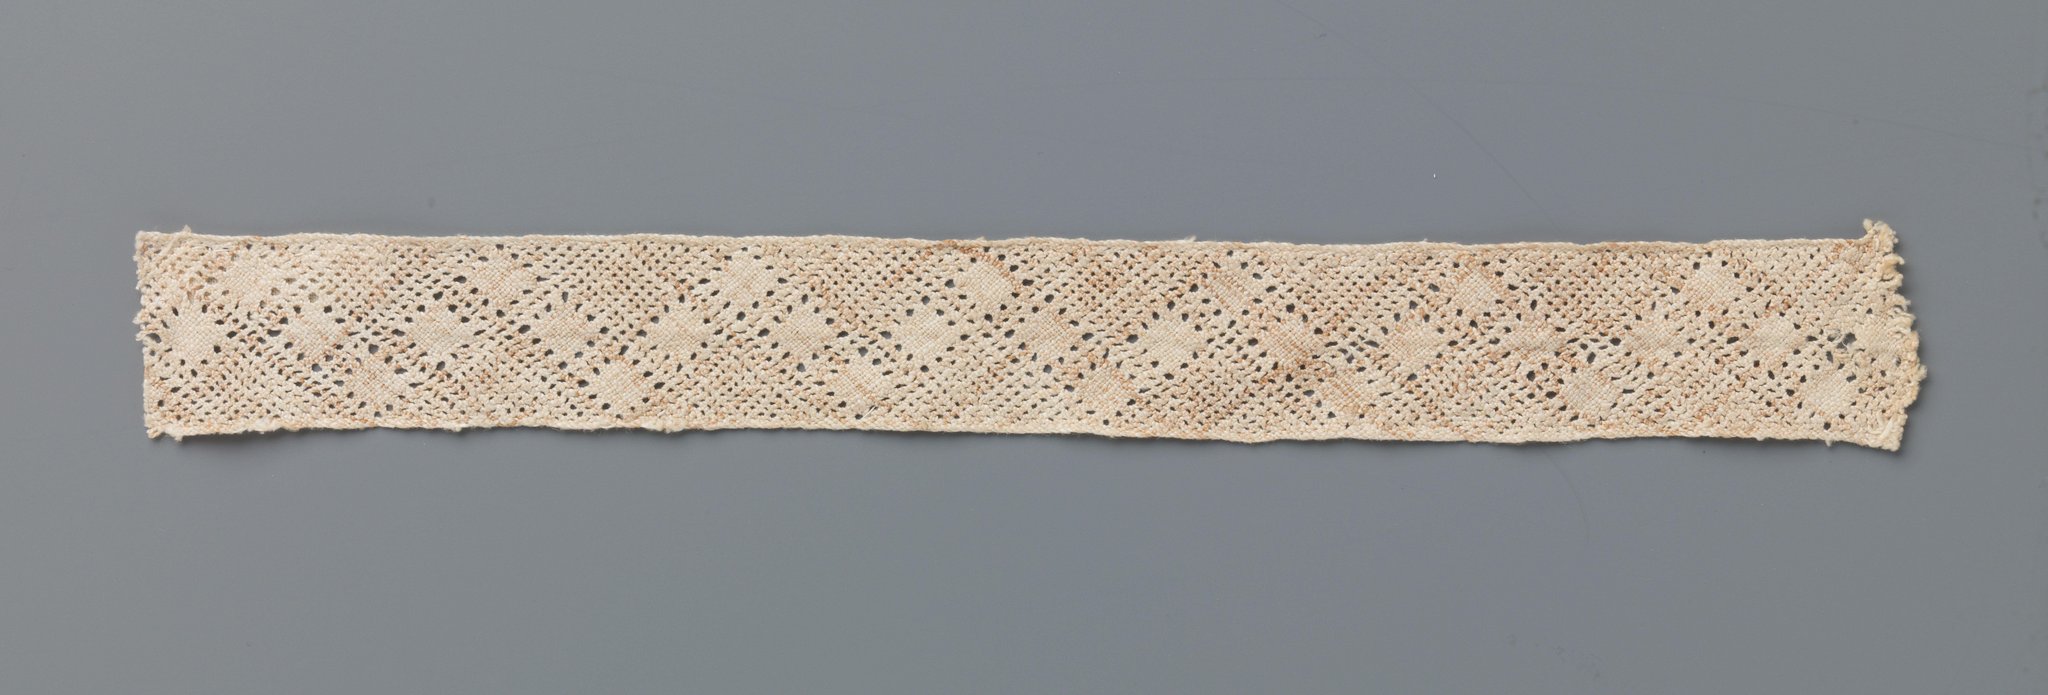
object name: entre deux, tussenzetsel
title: Tussenzetsel van kloskant met geometrisch zigzagpatroon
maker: Anonymous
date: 1500-1699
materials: linen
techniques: lace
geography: flanders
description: Tussenzetsel van naturelkleurige kloskant met lichtere en iets donkerdere draden. Het geometrische patroon bestaat uit een zigzaglijn van steeds drie vierkantjes omhoog en drie omlaag. De vierkantjes zijn gemaakt in linnenslag, ze zijn stuk voor stuk omringd door een randje van kleine uitsparingen. De vlechtengrond is dichtgewerkt, de mazen zijn klein.